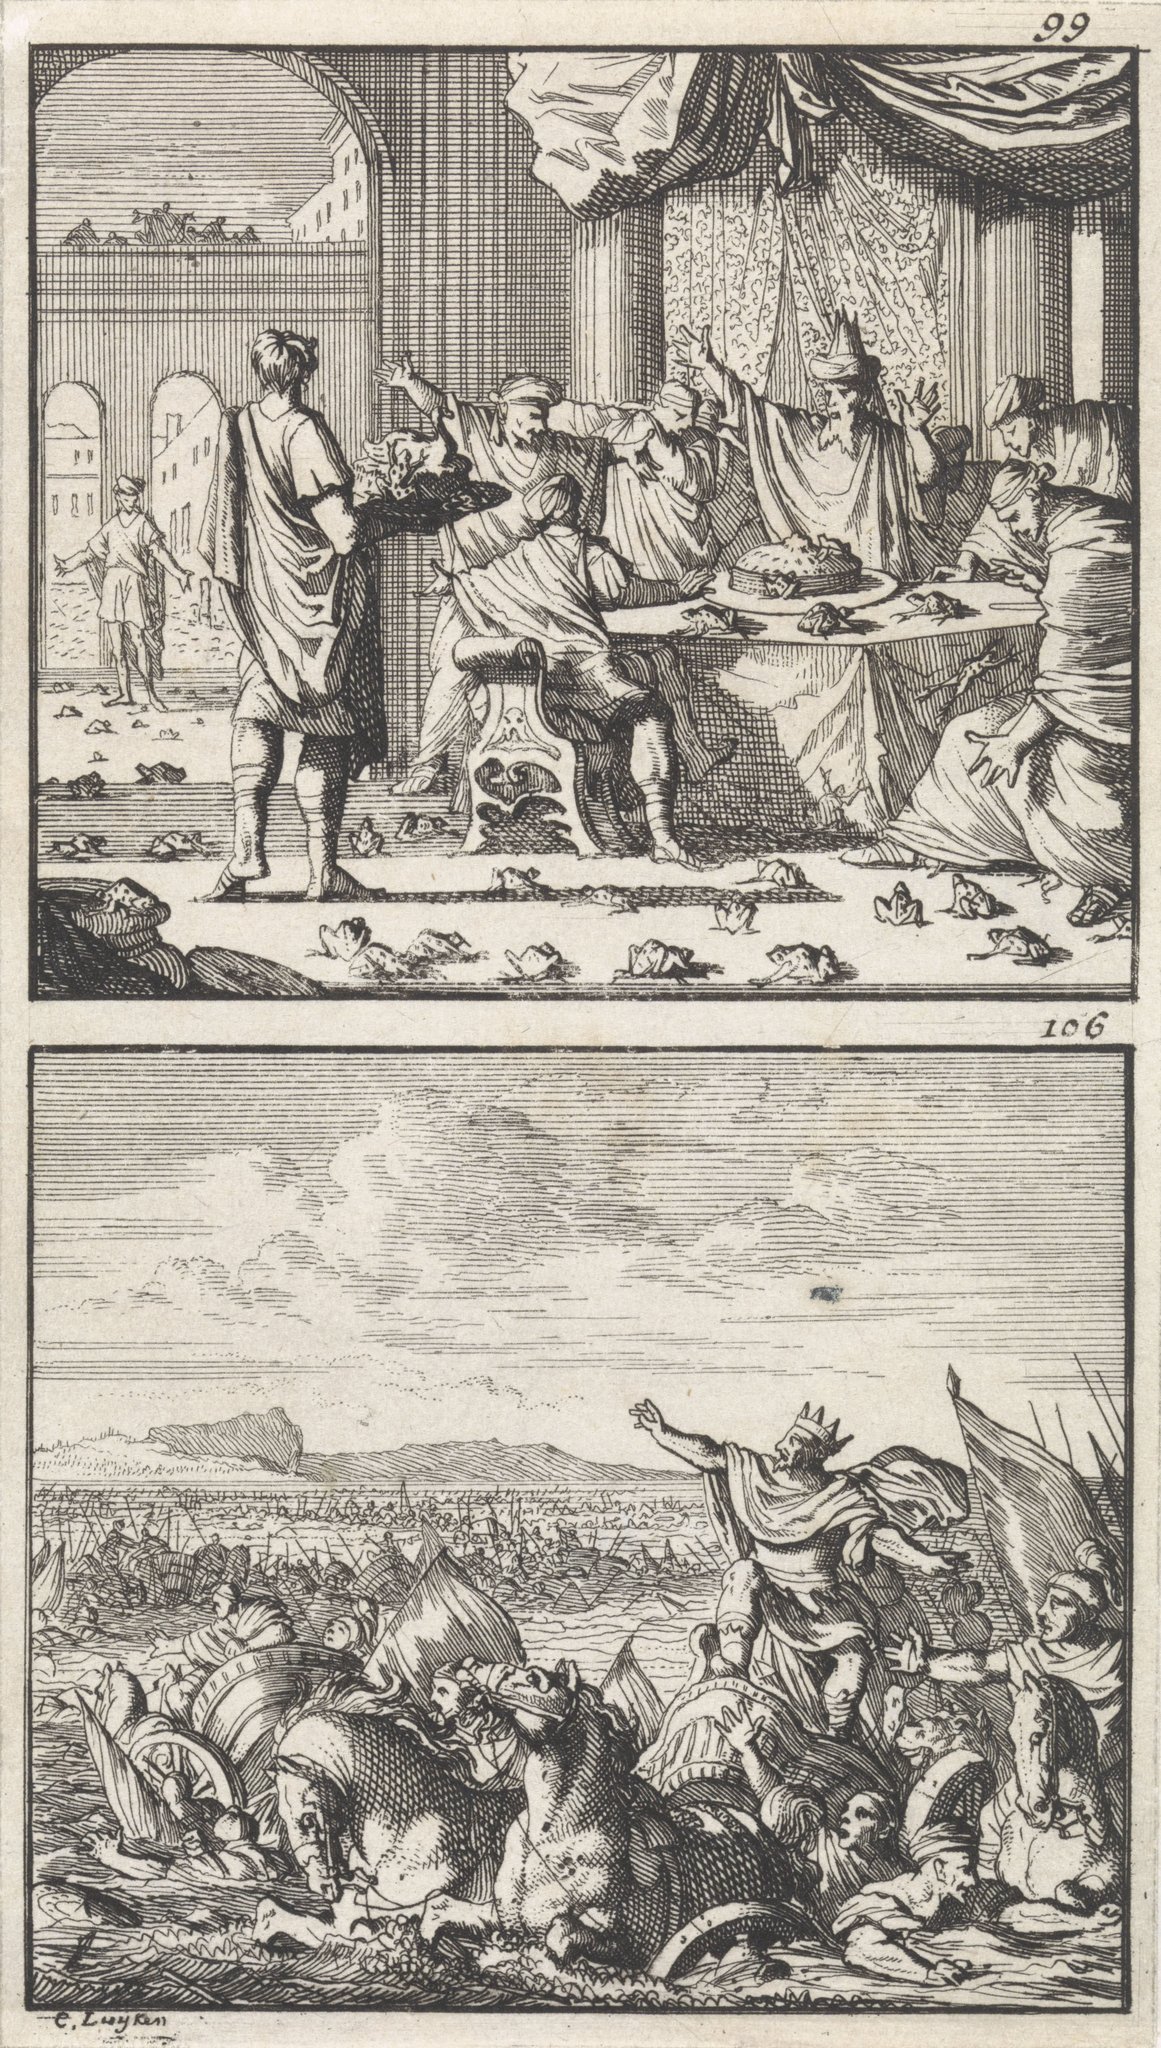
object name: print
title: Plaag van de kikkers / Farao's leger verdrinkt in de Rode Zee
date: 1698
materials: paper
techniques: etching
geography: amsterdam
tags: the plague of frogs: aaron stretches out his hand over the water of egypt; frogs come out and cover the land, with his people safe on the shore, moses raises his hands and causes the water to return; pharaoh's army perishes in the water (red sea)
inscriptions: collector's mark: Lugt 2228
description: Illustratie uit: Josephus, Flavius. XX. boeken van de oude geschiedenissen der joden, 4 delen. Amsterdam: Barent Visscher, Willem de Coup, Willem van Lamsveld, Andries van Damme, 1698, dl. I.